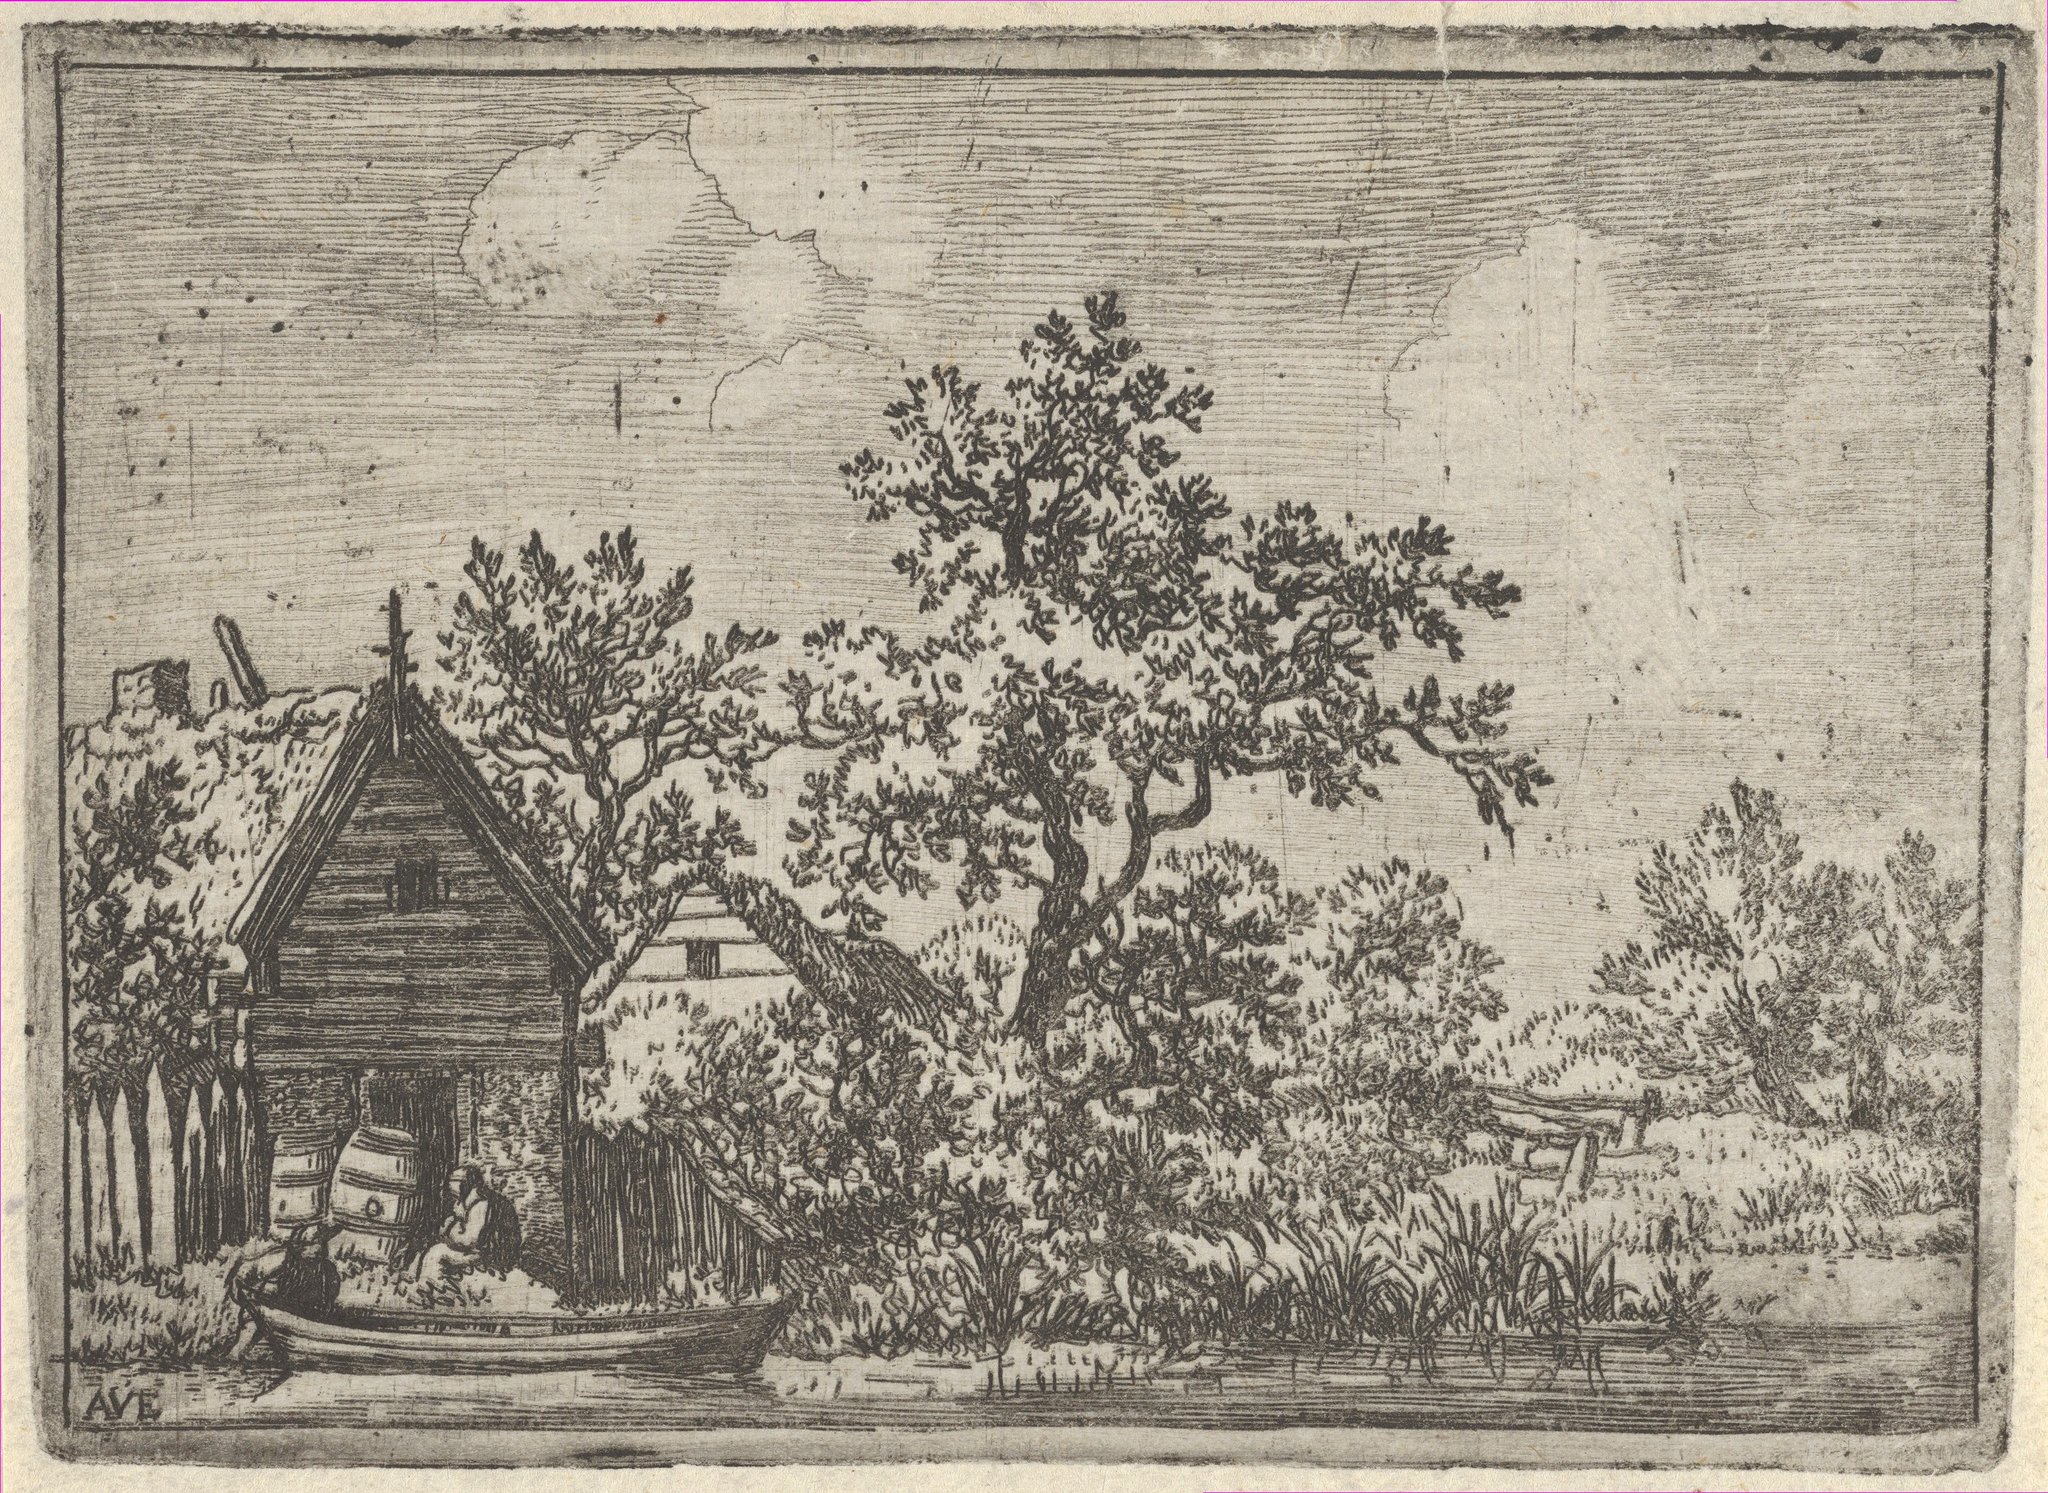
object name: print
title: The Two Barrels before a Hut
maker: allart van everdingen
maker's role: artist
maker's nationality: dutch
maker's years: 1621-1675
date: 1621-1675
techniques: engraving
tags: human figures,houses,trees,boats